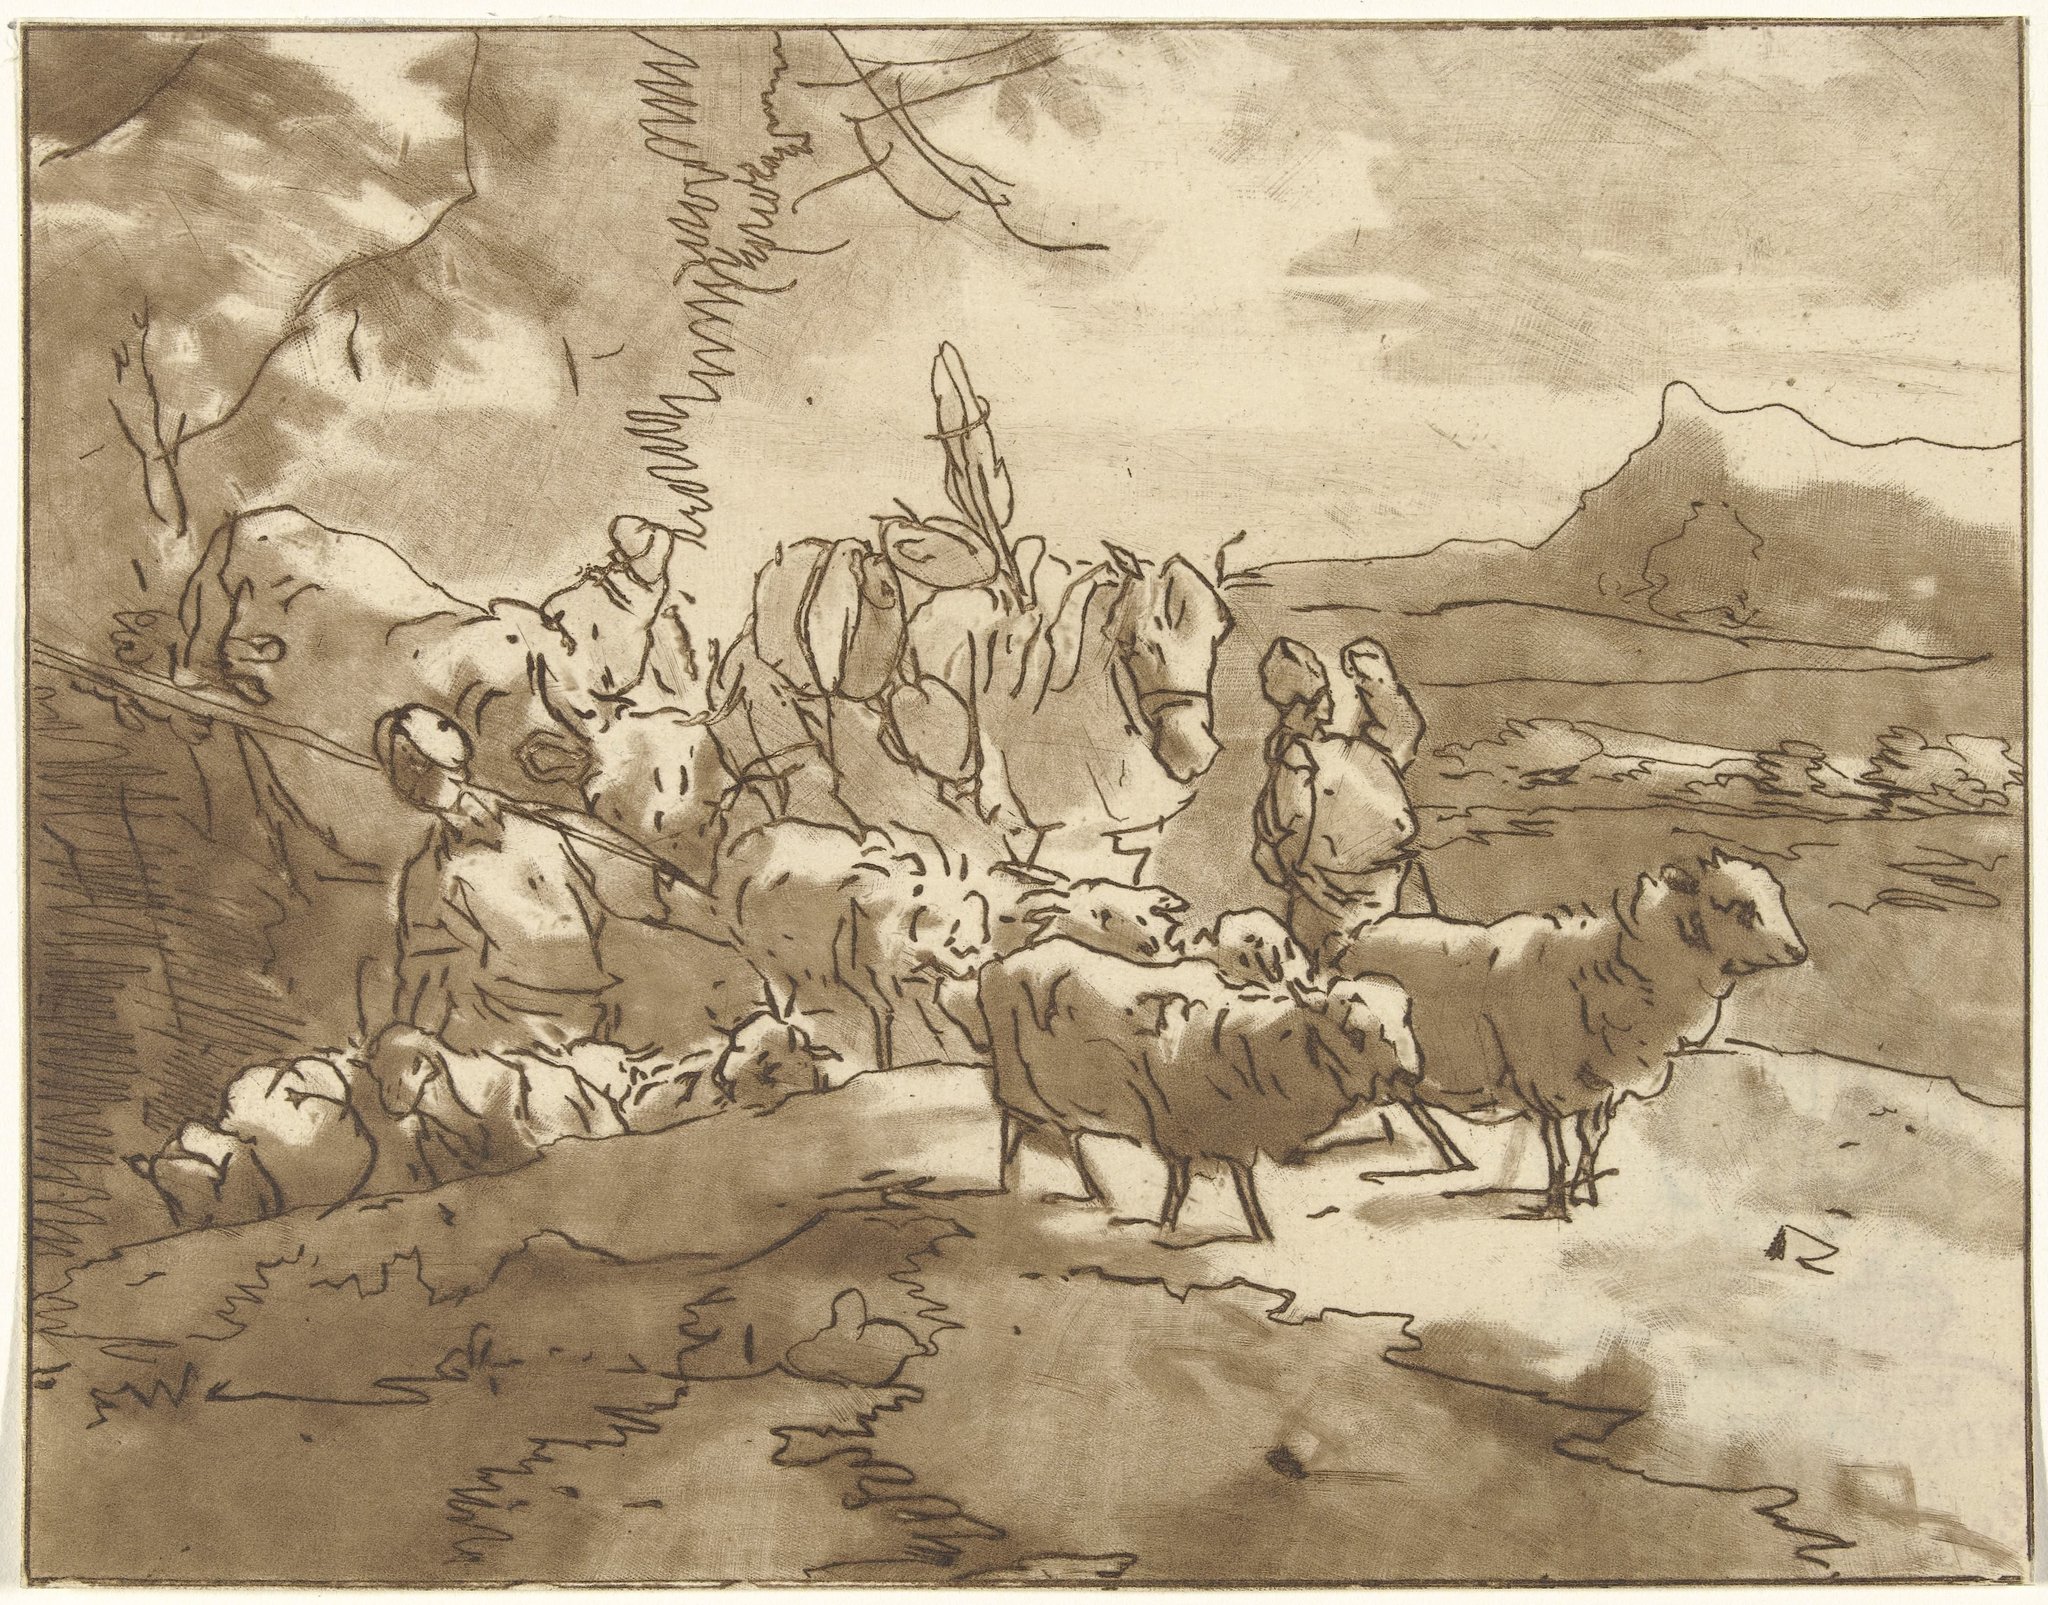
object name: print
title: Landschap met herders en vee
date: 1821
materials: paper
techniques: etching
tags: landscapes (+ landscape with figures, staffage)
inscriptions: collector's mark: Lugt 2725, collector's mark: Lugt 12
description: Door Christiaan Josi opgenomen in een uitgave met 100 werken naar Hollandse en Vlaamse meesters: Collection d'imitations de dessins d'après les principaux maîtres hollandais et flamands, Londen, C.Josi, 1821. Alle prenten in deze uitgave dragen op het verso het wapen van Cornelis Ploos van Amstel, de initiatiefnemer voor de uitgave.